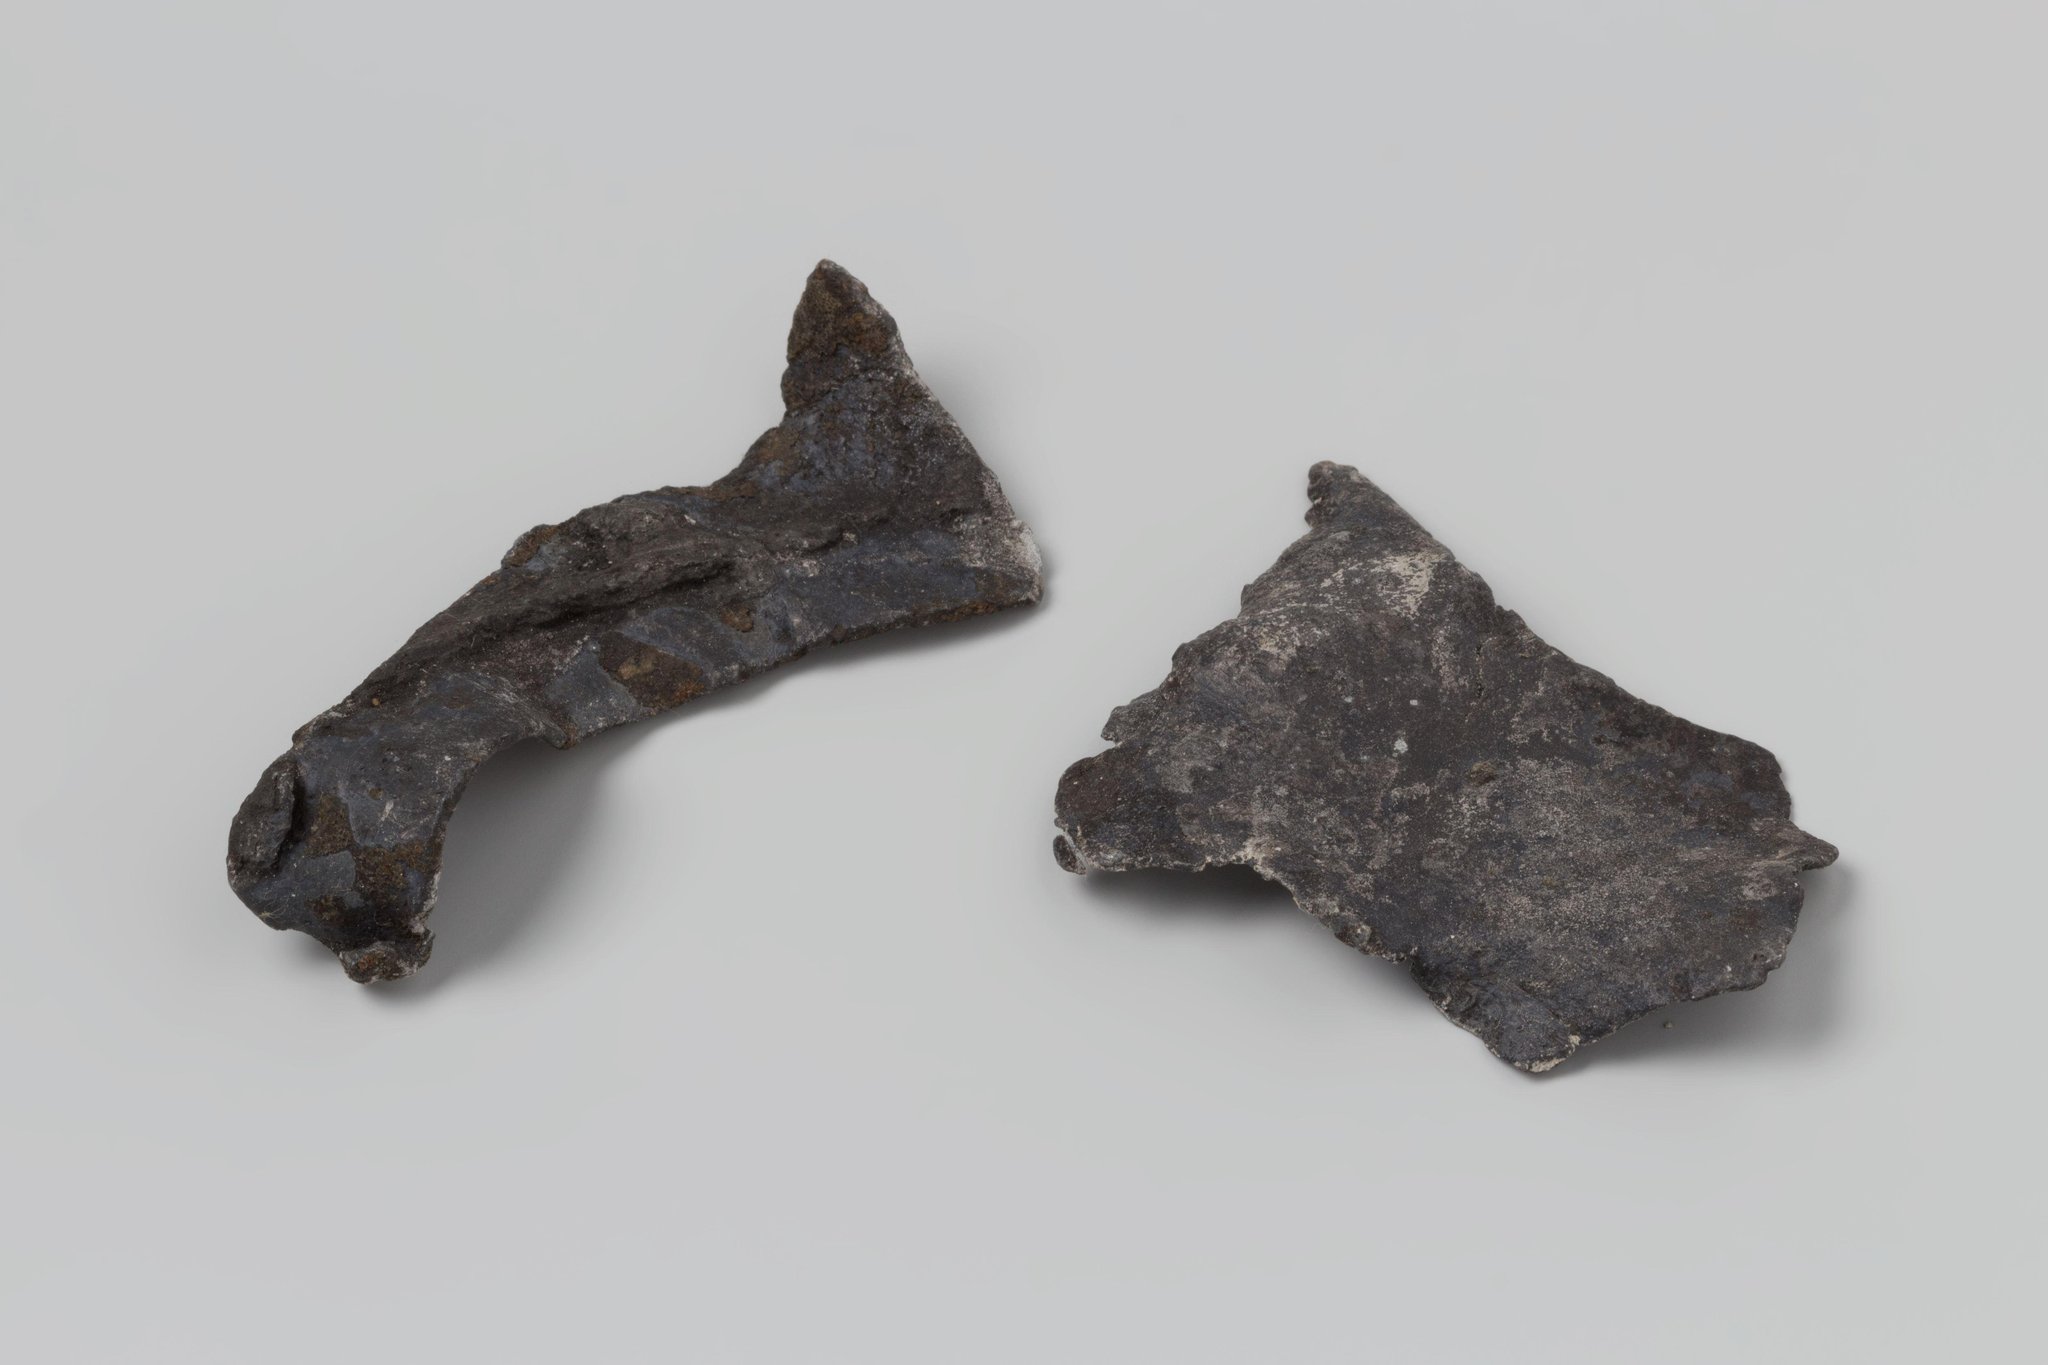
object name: sheet lead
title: Fragment van een loodplaat uit het wrak van de Oost-Indiëvaarder 't Vliegend Hart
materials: lead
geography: middelburg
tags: 't vliegend hart (schip), verenigde oostindische compagnie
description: Twee stukken lood, gecorrodeerd en gebutst, zonder gaten. Sheet fragments.